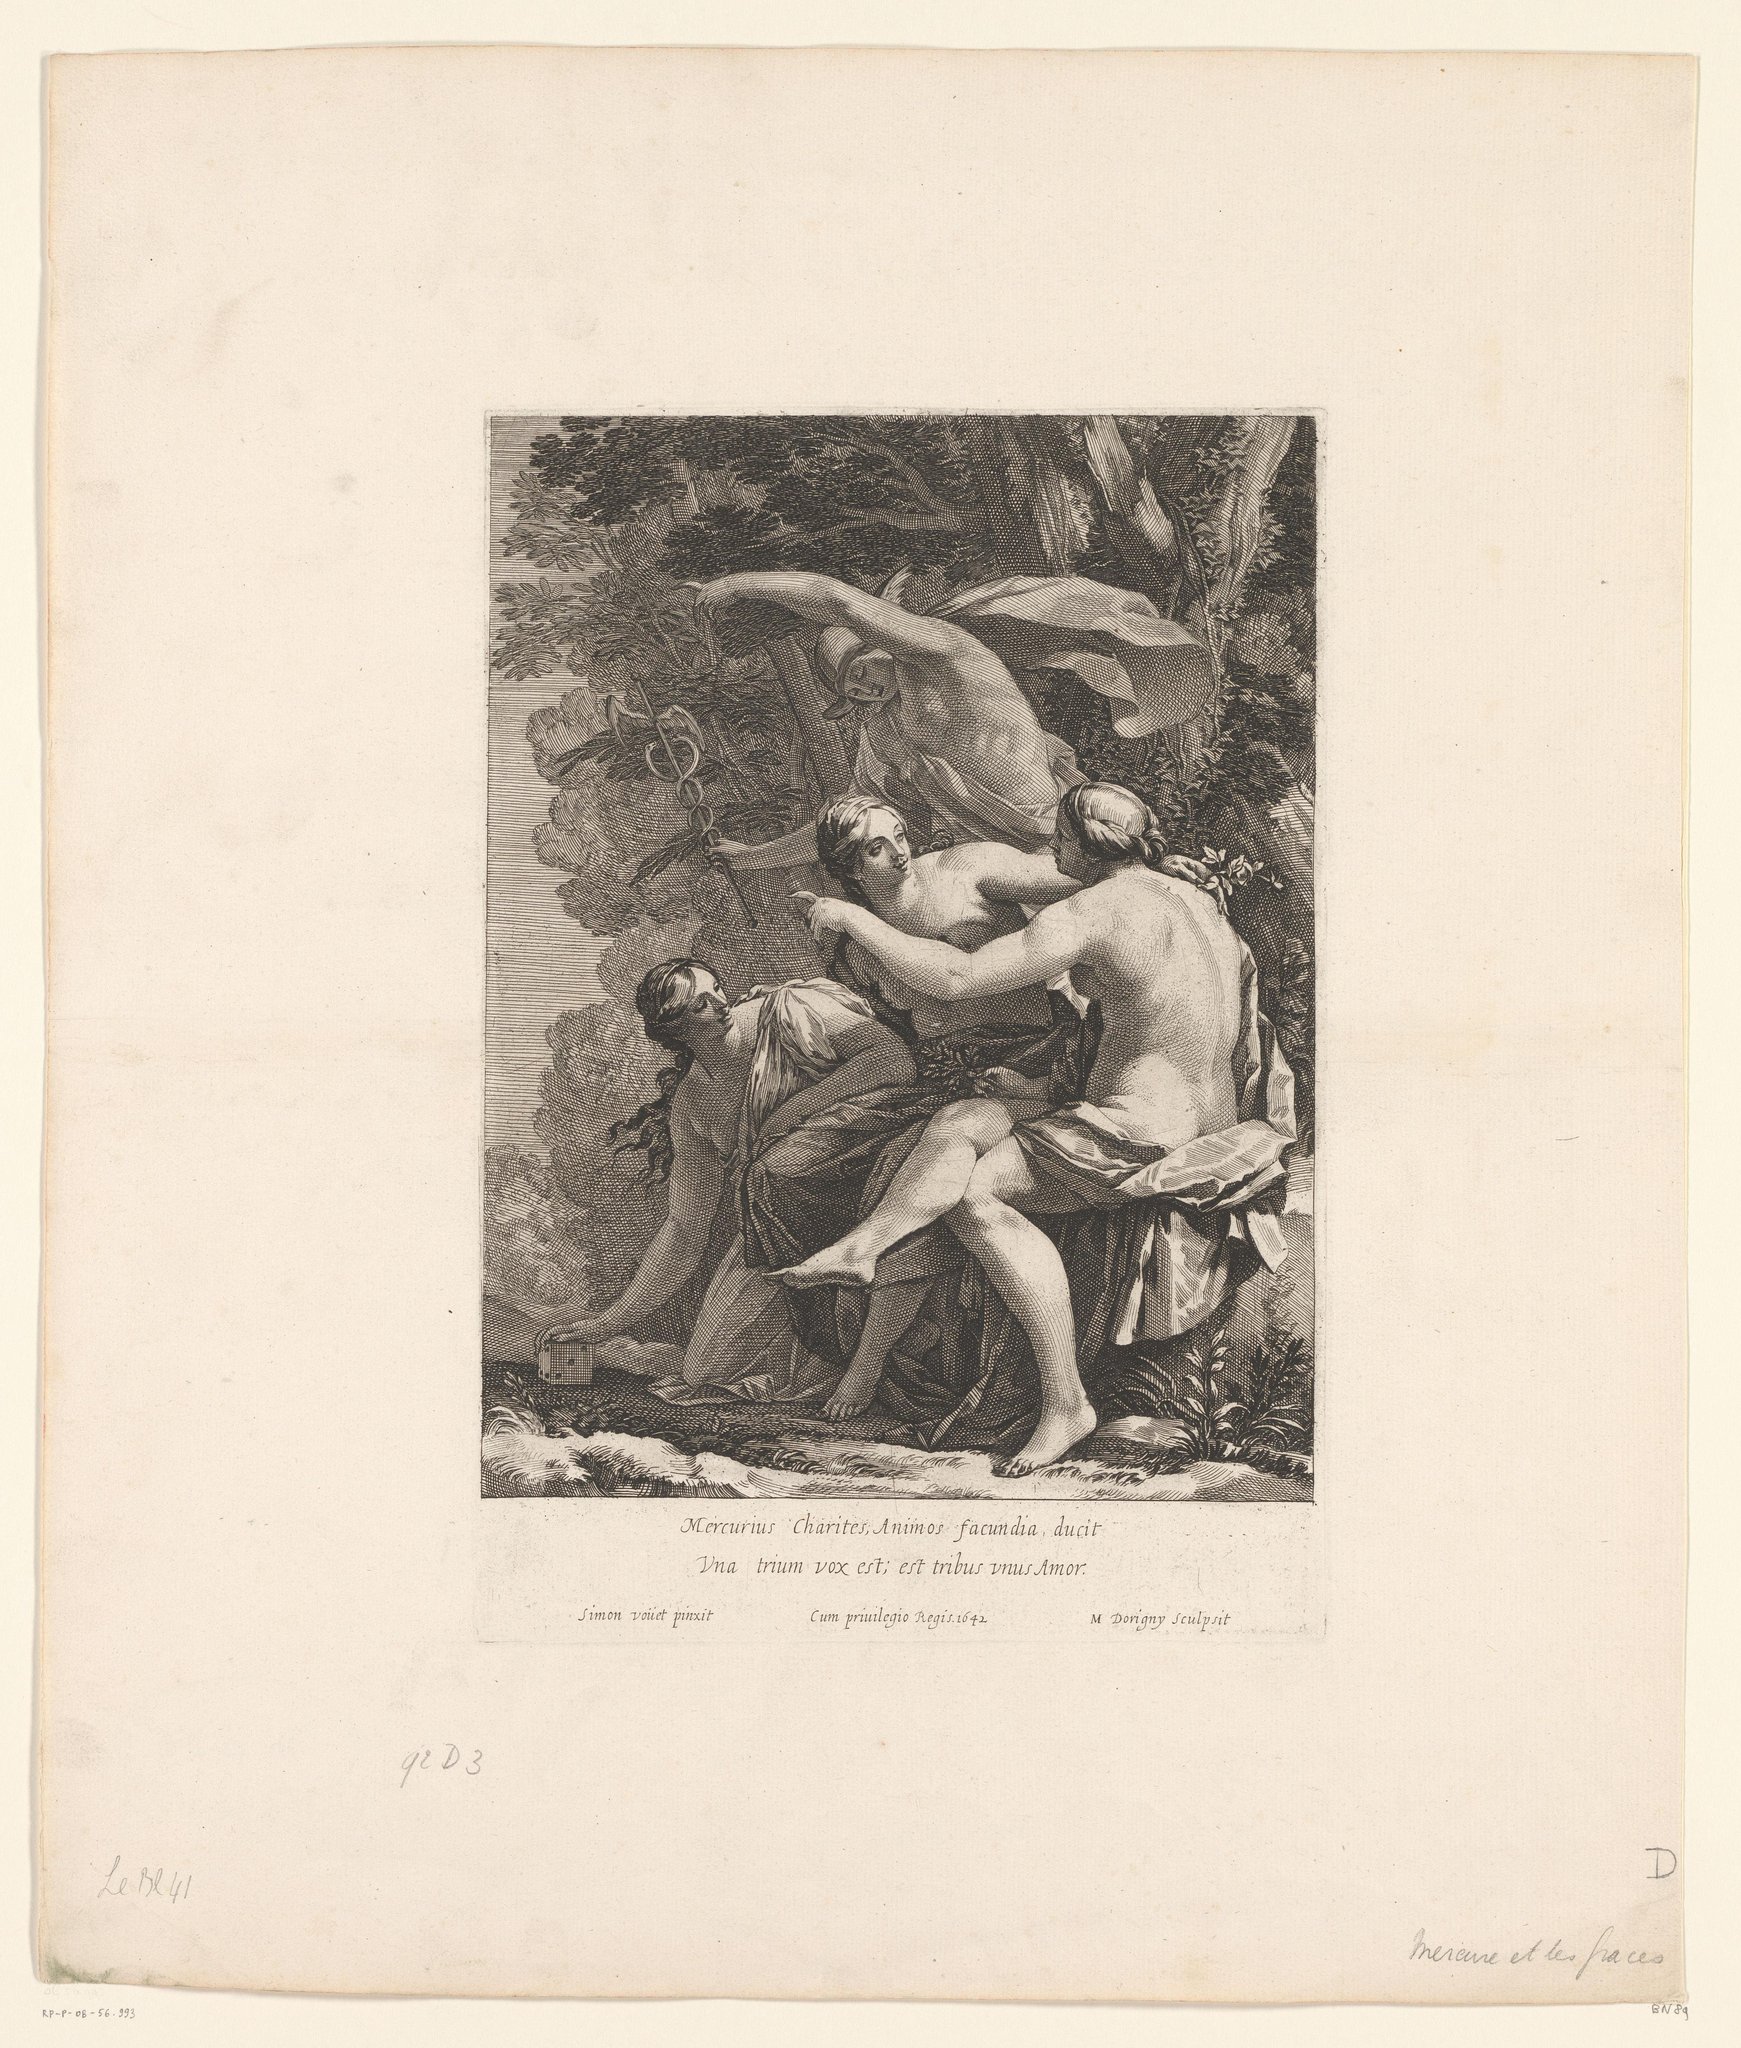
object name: print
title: Mercurius en de Gratiën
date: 1642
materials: paper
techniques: engraving, etching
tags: (story of) mercury (hermes), graces (charites), generally three in number; 'gratie' (ripa)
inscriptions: collector's mark: Lugt 2228